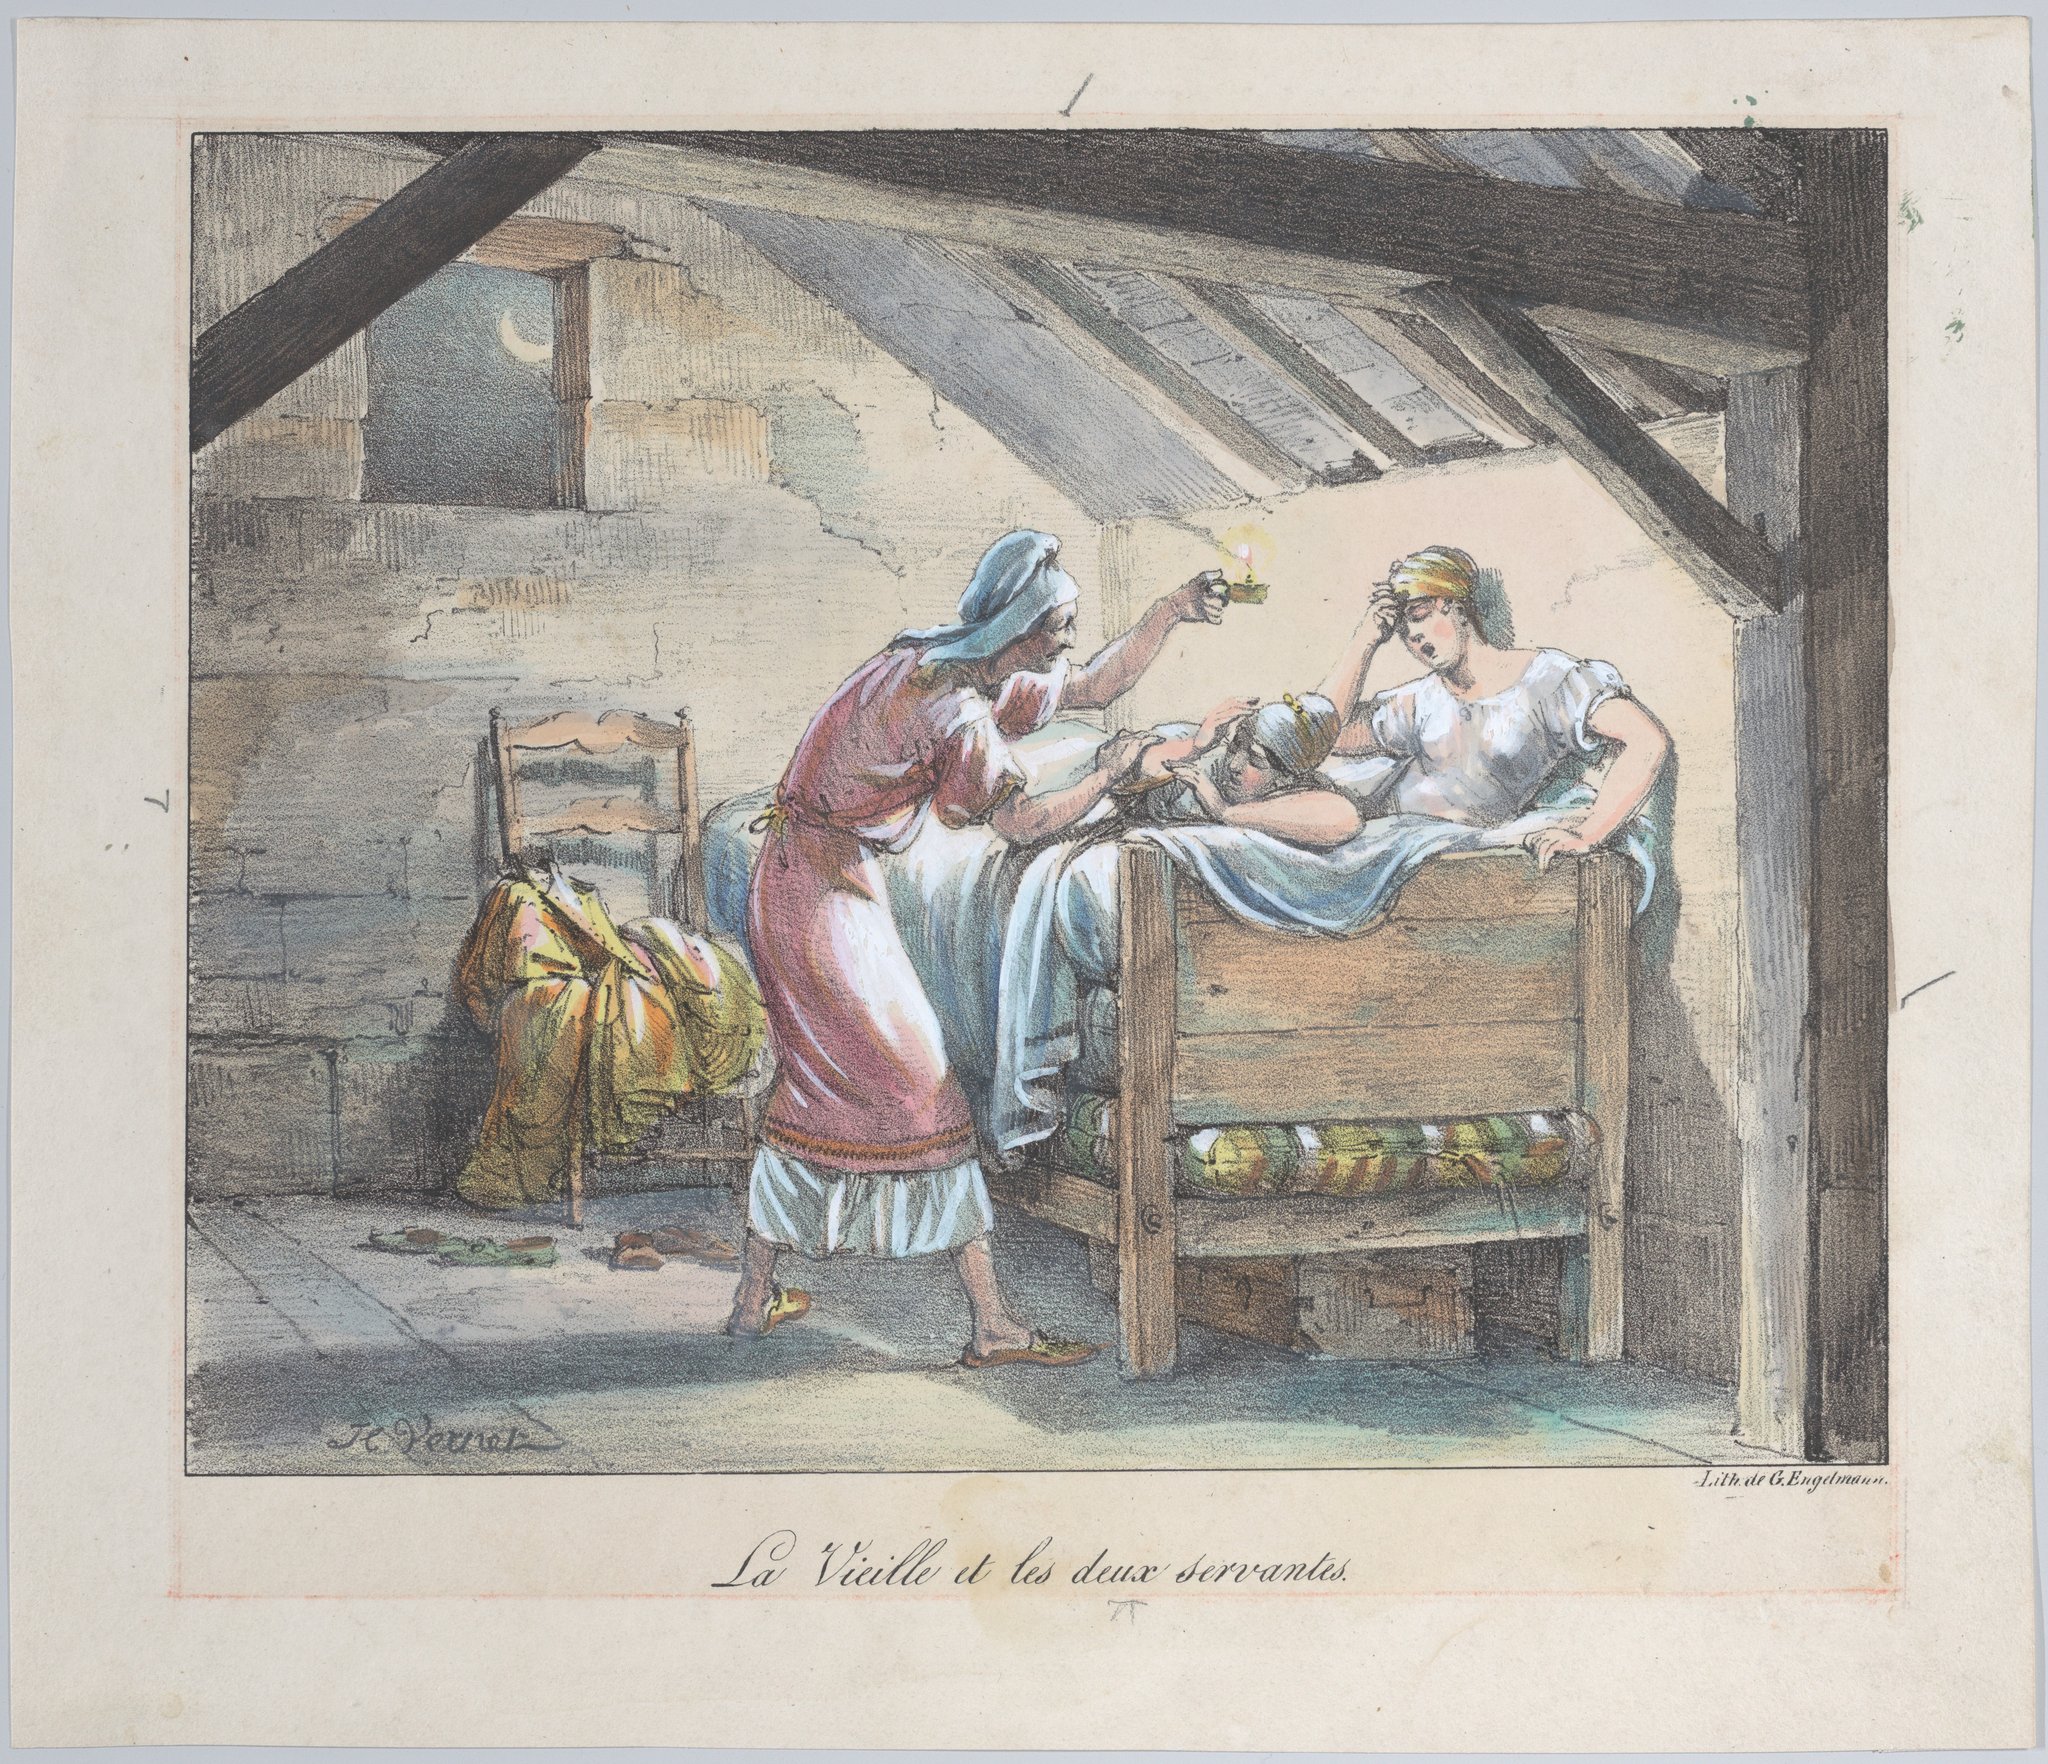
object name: print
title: The Old Woman and the Two Maids, plate no. 118 from "Fables choisies de La Fontaine ornées de figures lithographiques..."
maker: horace vernet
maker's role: artist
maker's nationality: french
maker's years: 1789-1863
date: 1818-1821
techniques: lithograph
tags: women,beds,chairs